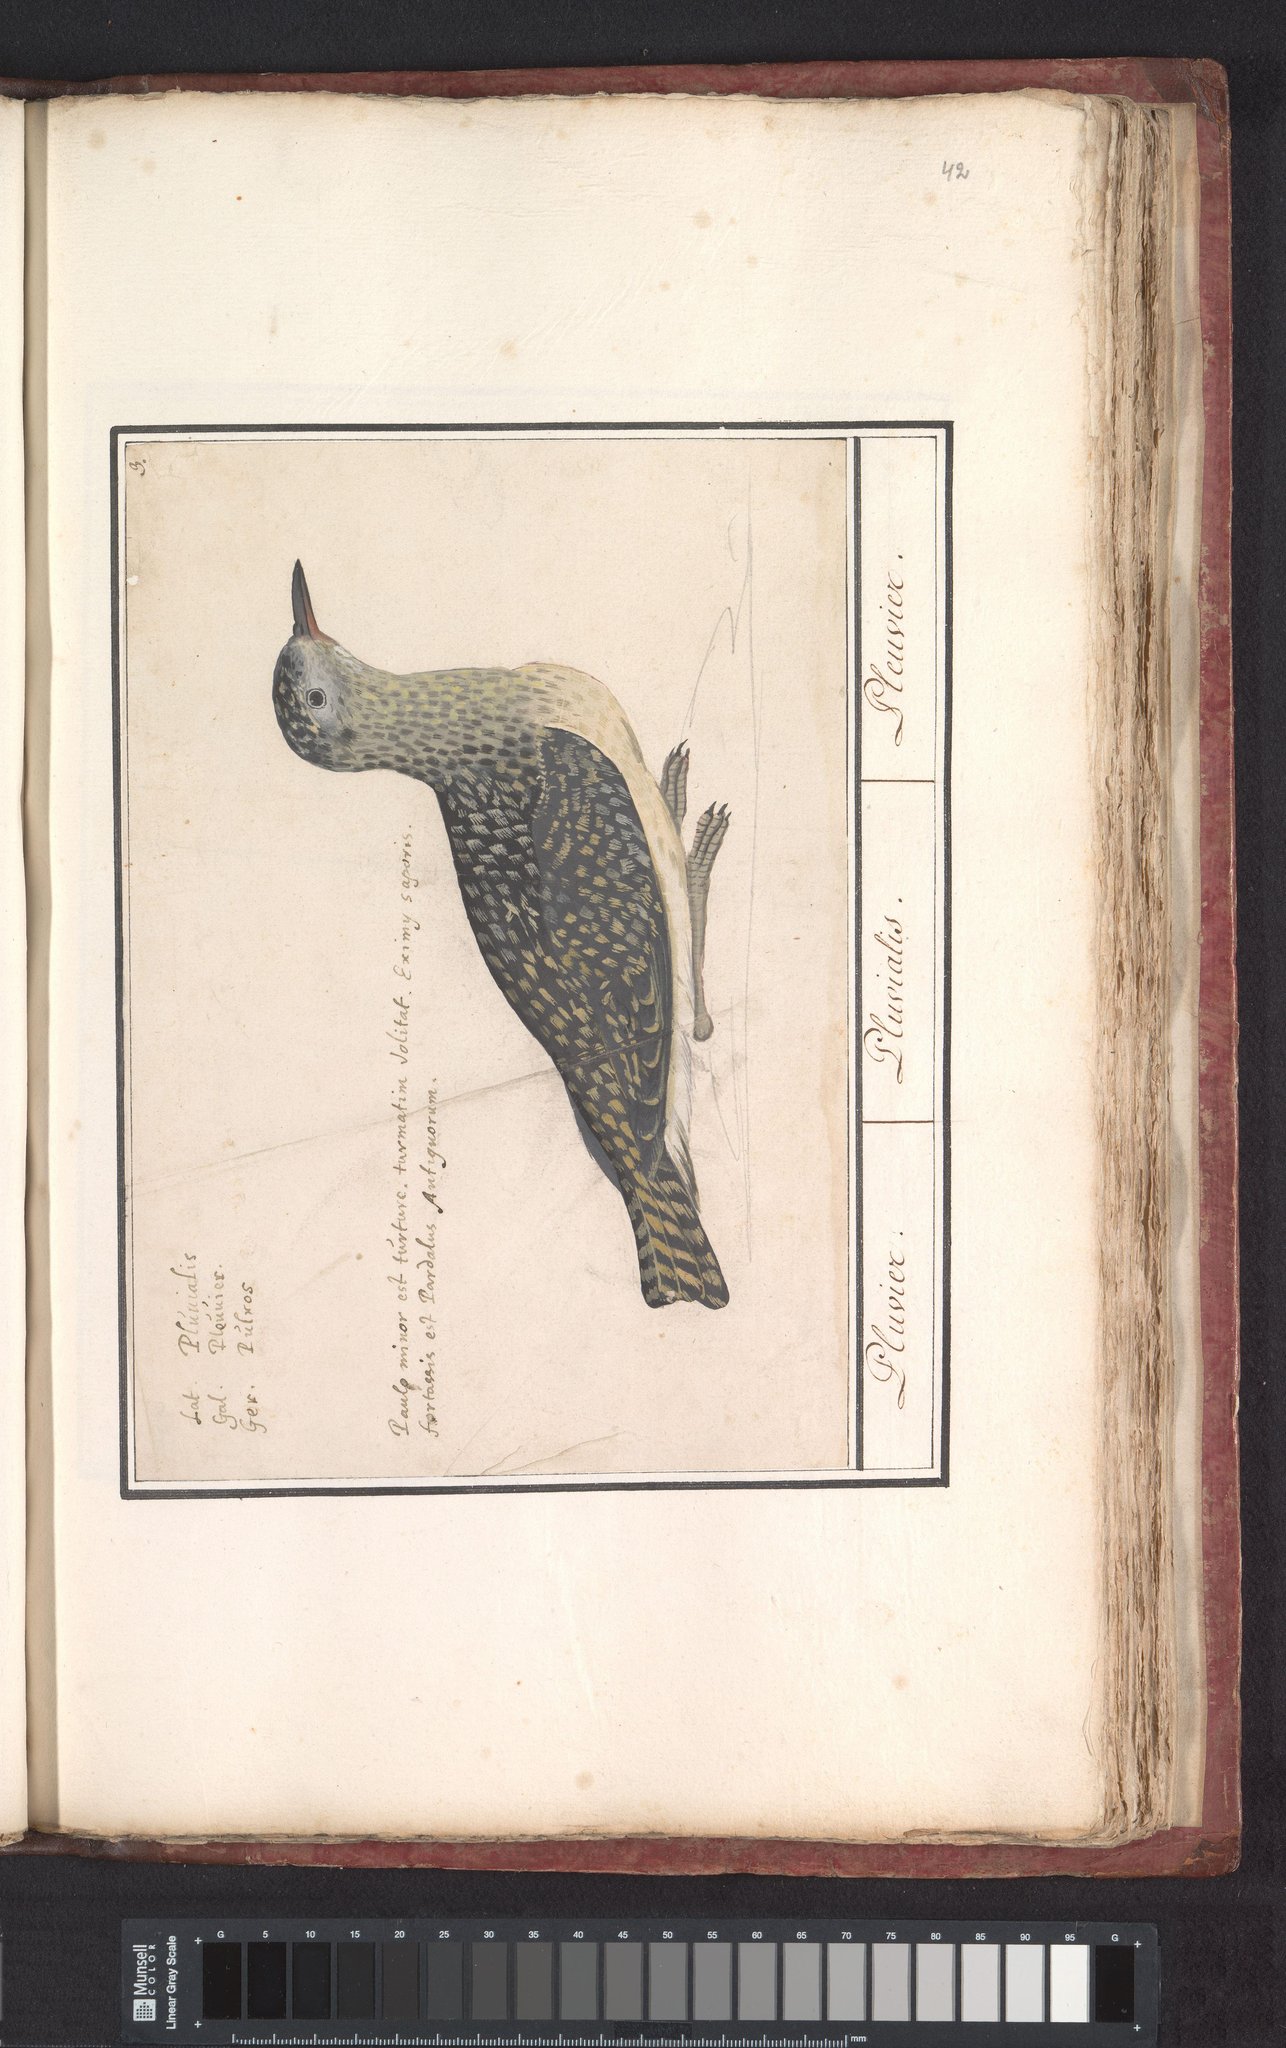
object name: drawing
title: Pluvier. / Pluvialis. / Pleuvier.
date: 1596-1610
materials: chalk, paint, ink, paper, pencil, watercolor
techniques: brush, pen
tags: shore-birds and wading-birds: golden plover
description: Goudplevier. Genummerd rechtsboven: 3. LInksboven de naam in drie talen. Met een tweeregelig opschrift in het Latijn. Onderdeel van het derde album met tekeningen van vogels. Vijfde van twaalf albums met tekeningen van dieren, vogels en planten bekend rond 1600, gemaakt in opdracht van keizer Rudolf II. Met toelichting in Nederlands, Latijn en Frans.